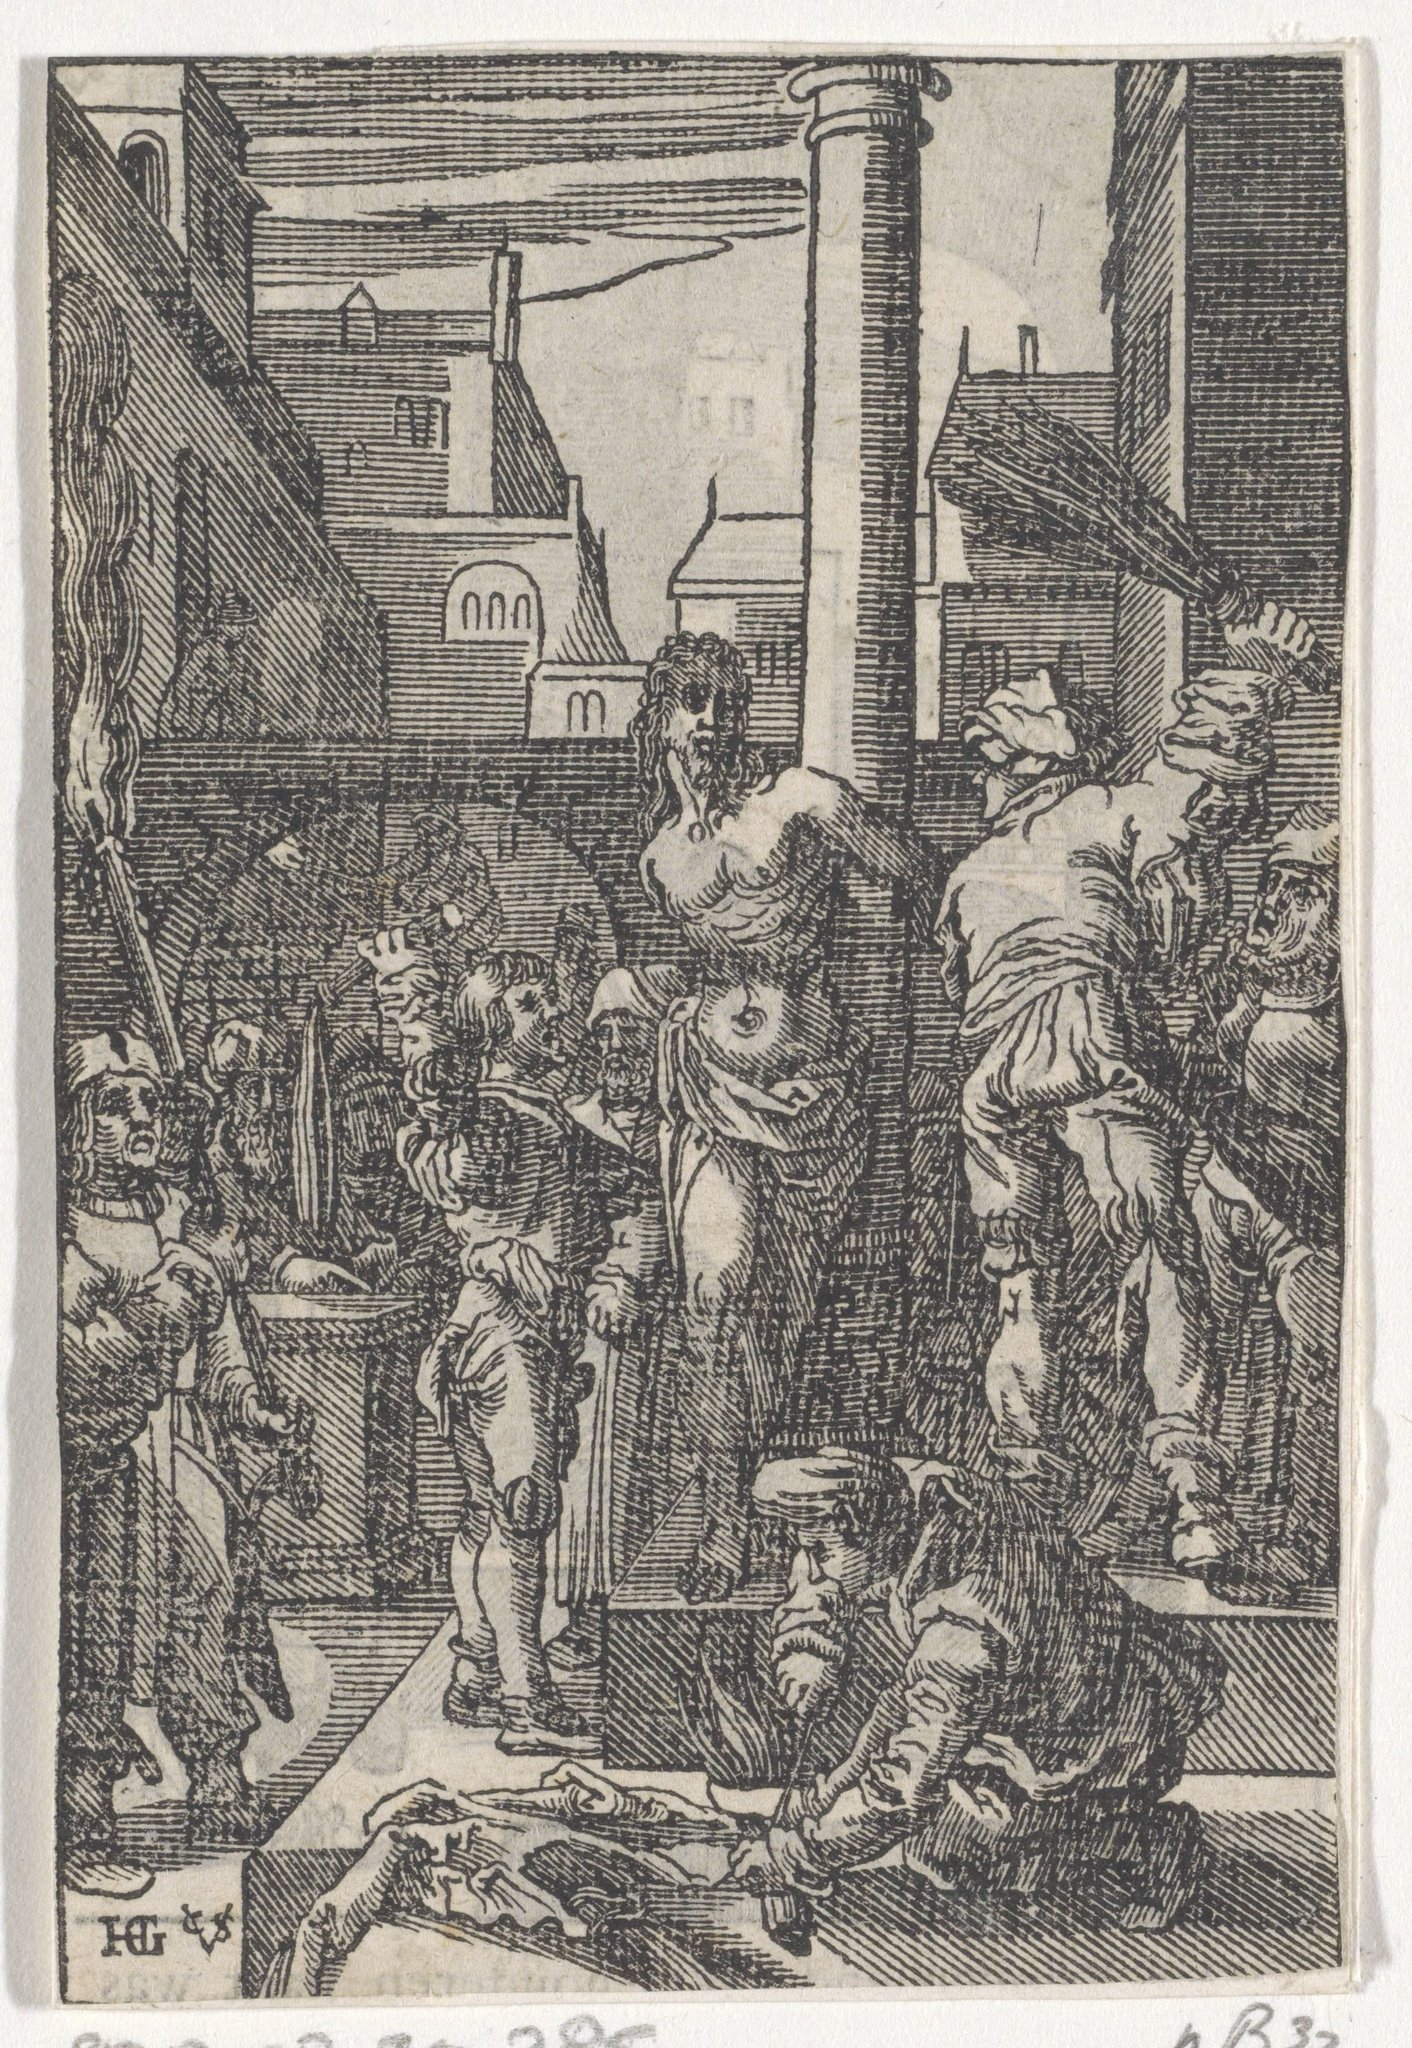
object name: book illustration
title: Geseling van Christus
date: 1648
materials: paper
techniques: woodcut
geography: amsterdam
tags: flagellation by soldiers, christ usually tied to a column (matthew 27:26; mark 15:15; john 19:1)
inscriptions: collector's mark: Lugt 240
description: Prent uit: Sichem, Christoffel van (II). 'tSchat der zielen, dat is: Het geheele leven ons Heeren Iesu Christi. Amsterdam: Pieter Jacobsz. Paets, 1648. Prent uit: Biblia sacra dat is De geheele Heylighe Schrifture bedeylt in 't Out en Nieu Testament. Amsterdam: Pieter Jacobsz. Paets, 1657.